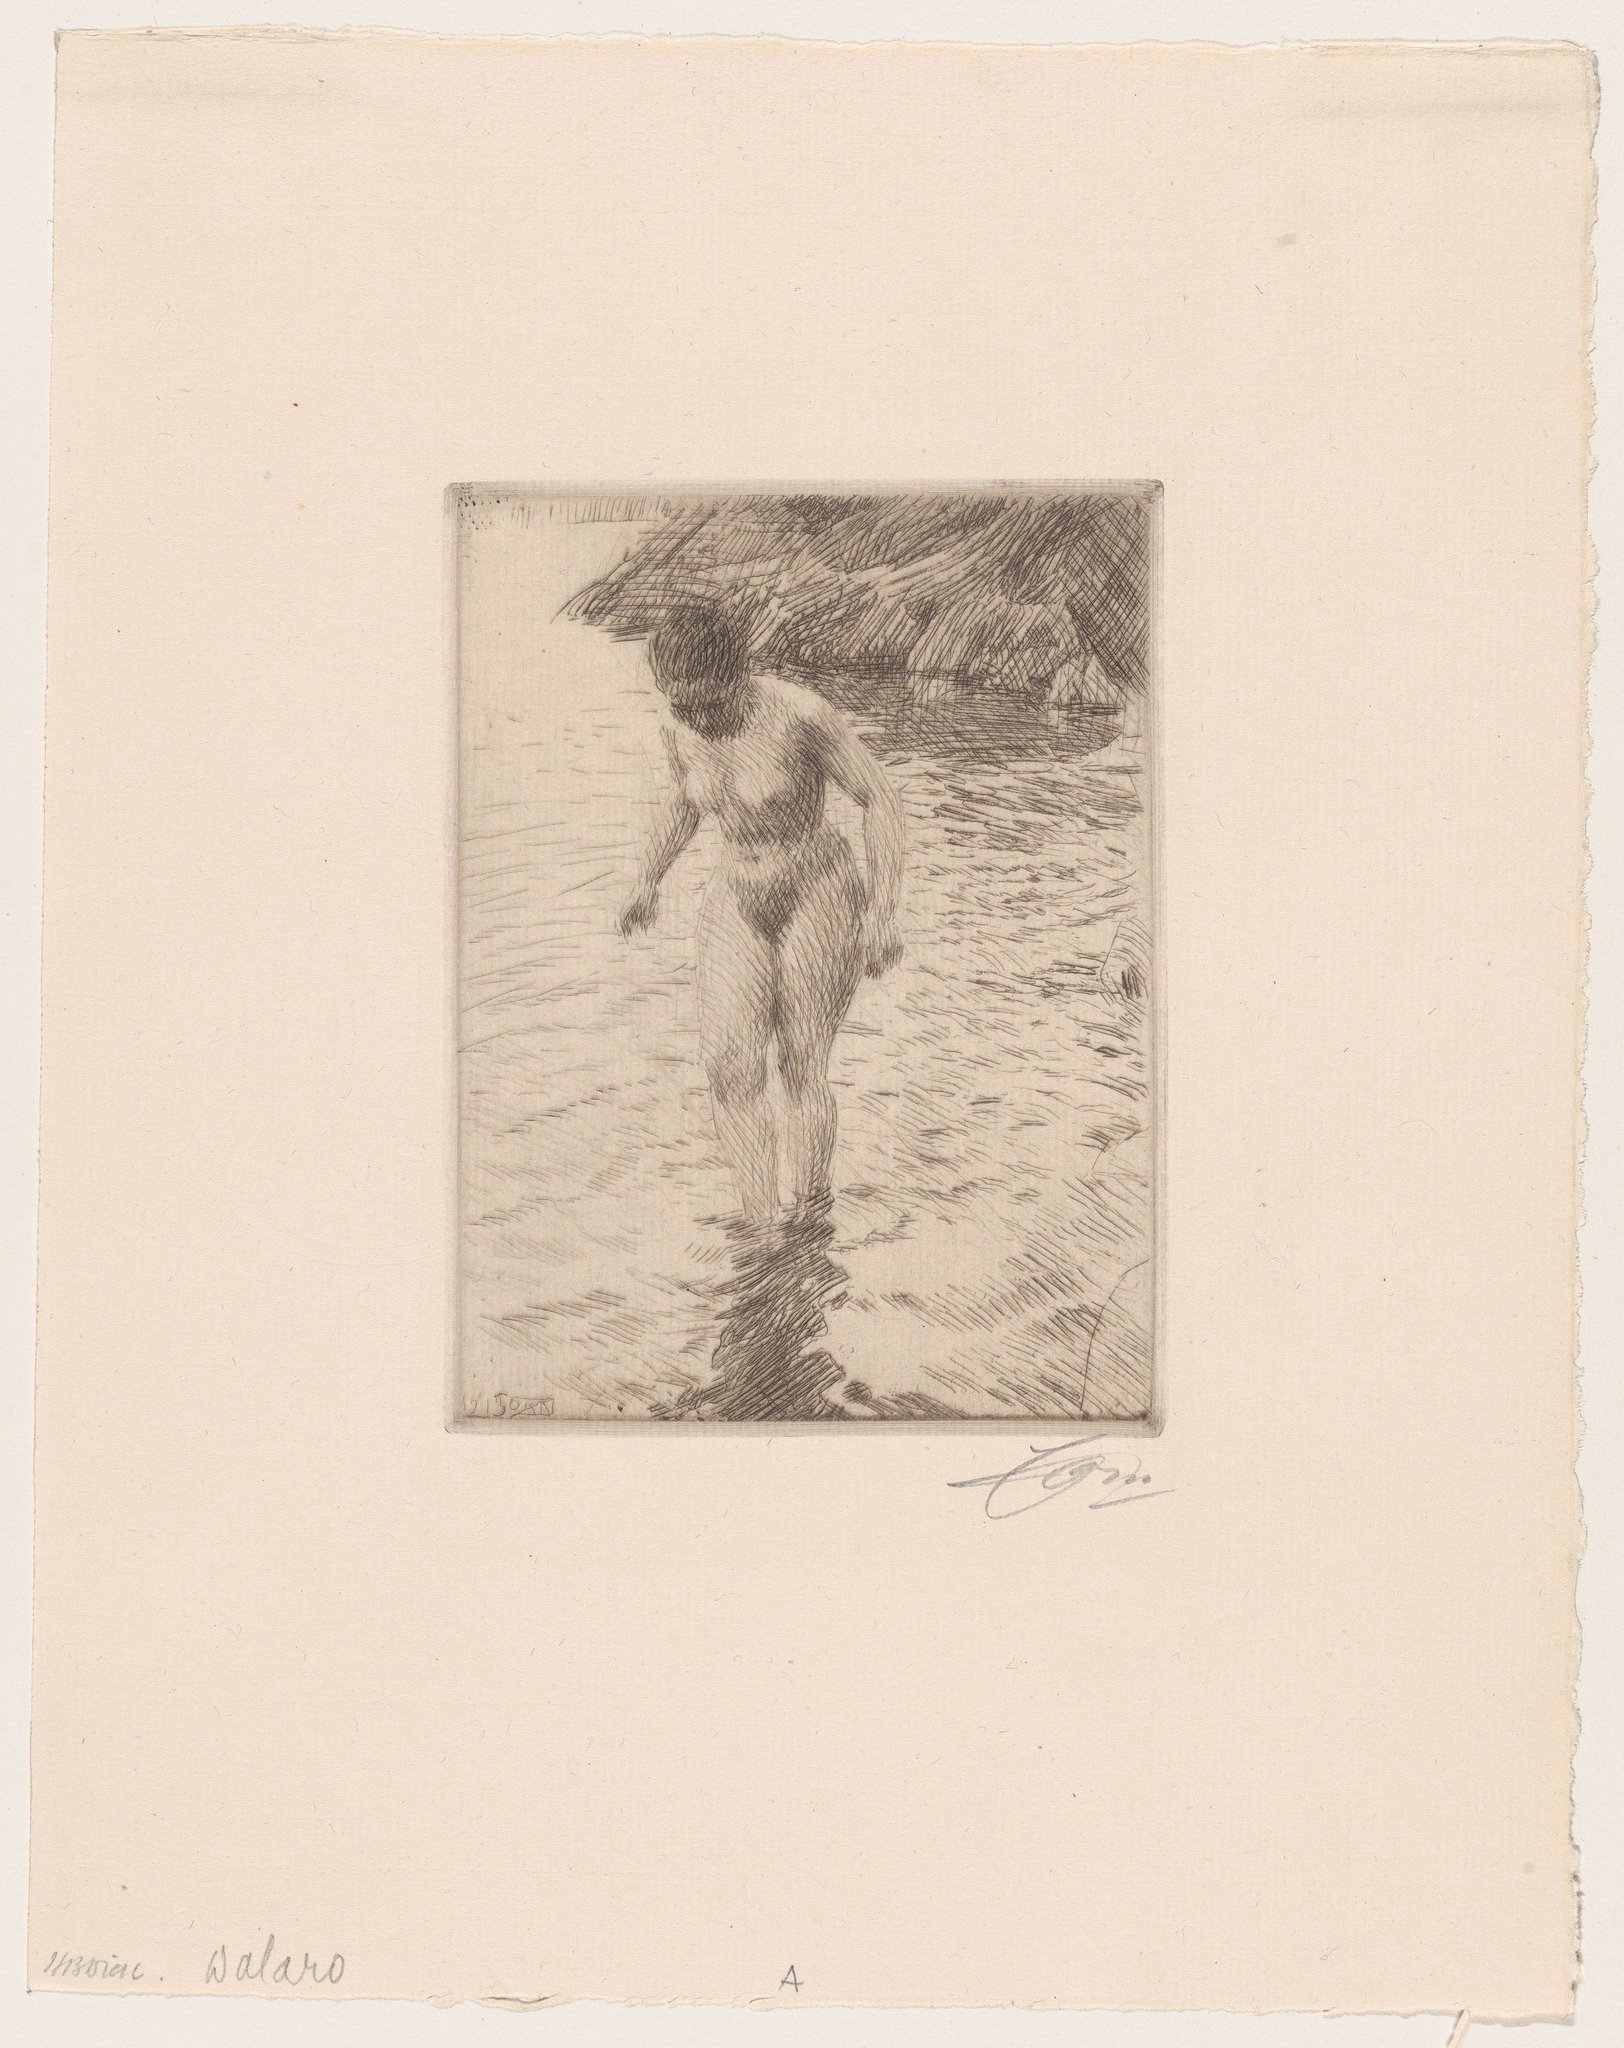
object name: print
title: Dalarö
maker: anders zorn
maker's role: artist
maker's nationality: swedish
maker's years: 1860-1920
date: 1915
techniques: etching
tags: female nudes